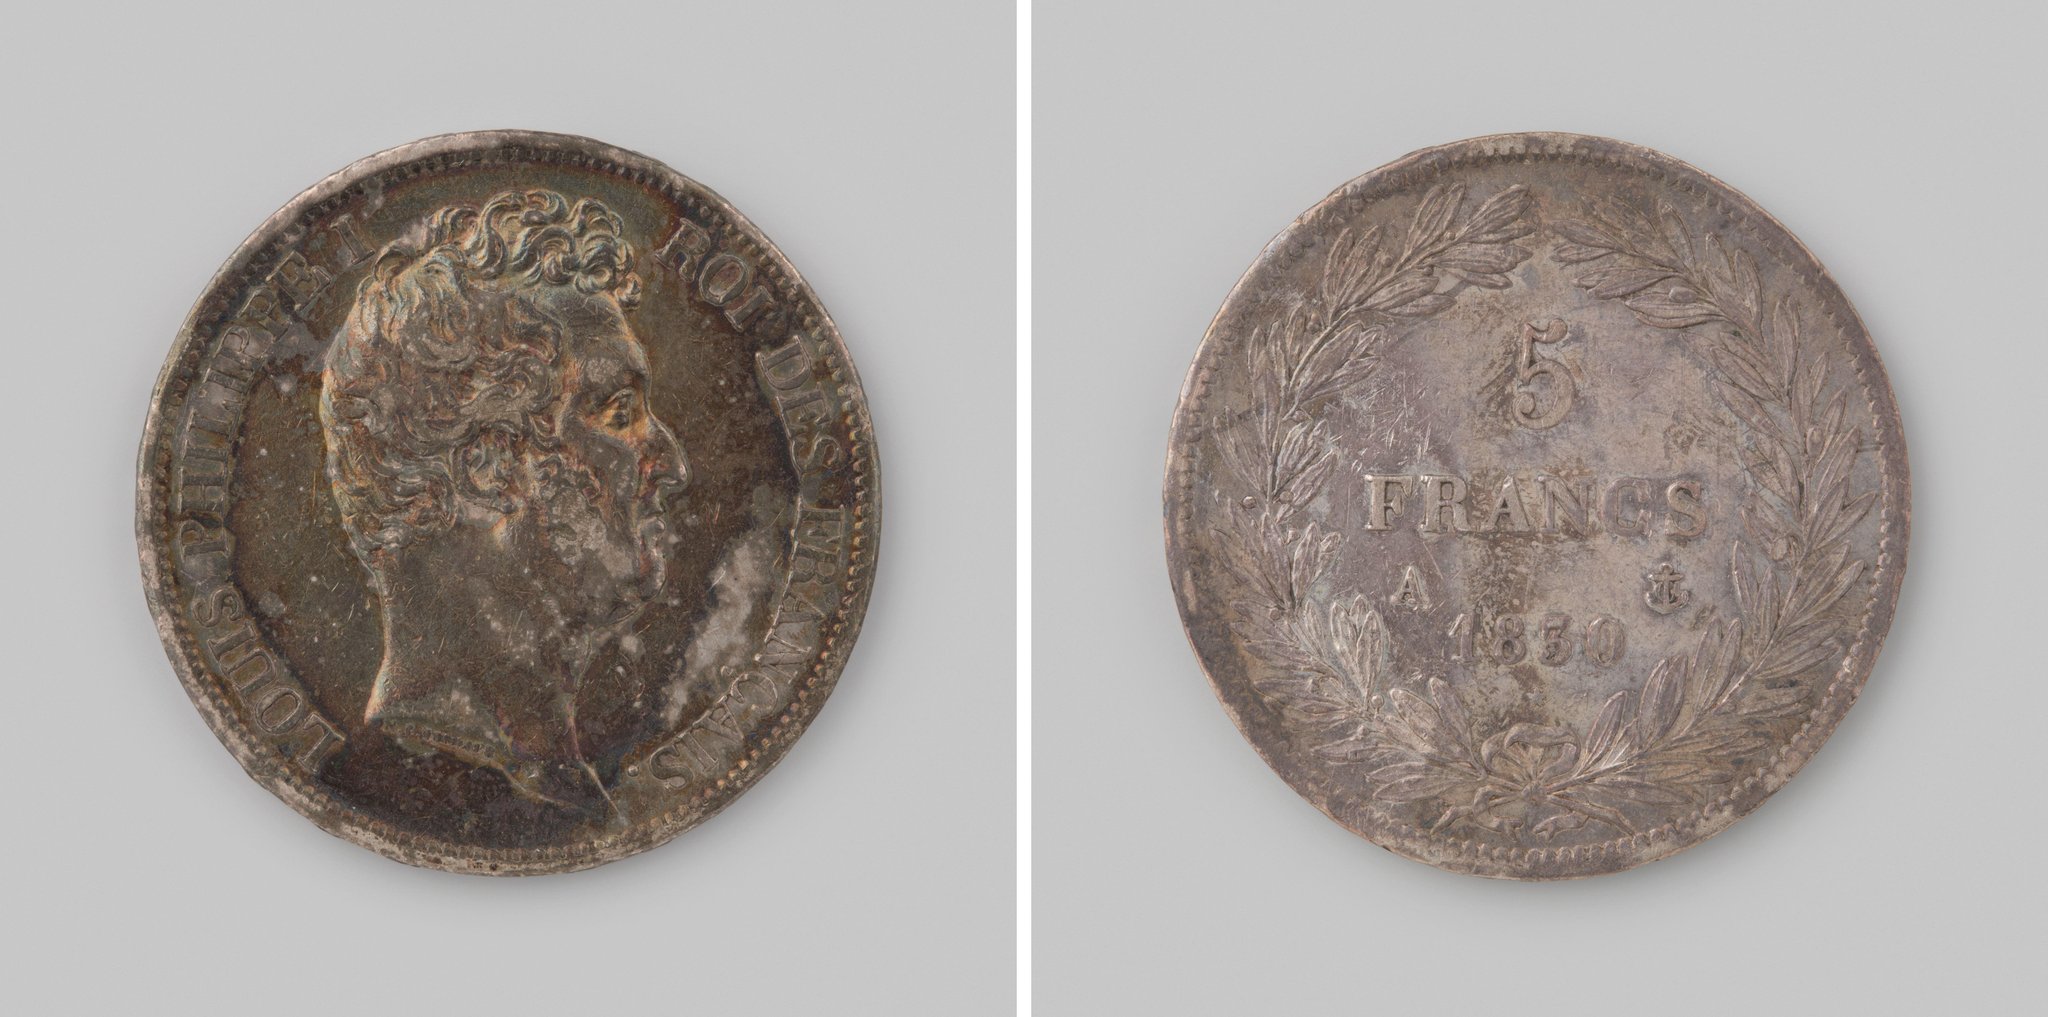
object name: vijf franc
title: Koninkrijk Frankrijk, Louis Philippe (I), 5 francs, 1830 A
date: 1830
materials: silver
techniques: striking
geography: paris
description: Zilveren munt. Voorzijde: hoofd van de koning naar rechts. Omschrift: Louis Philippe roi des Francais. Keerzijde: binnen twee samengebonden lauriertakken waarde-aanduiding in twee regels, waaronder jaartal. Links daarvan letter A [=Parijs]. Opliggend randschrift.